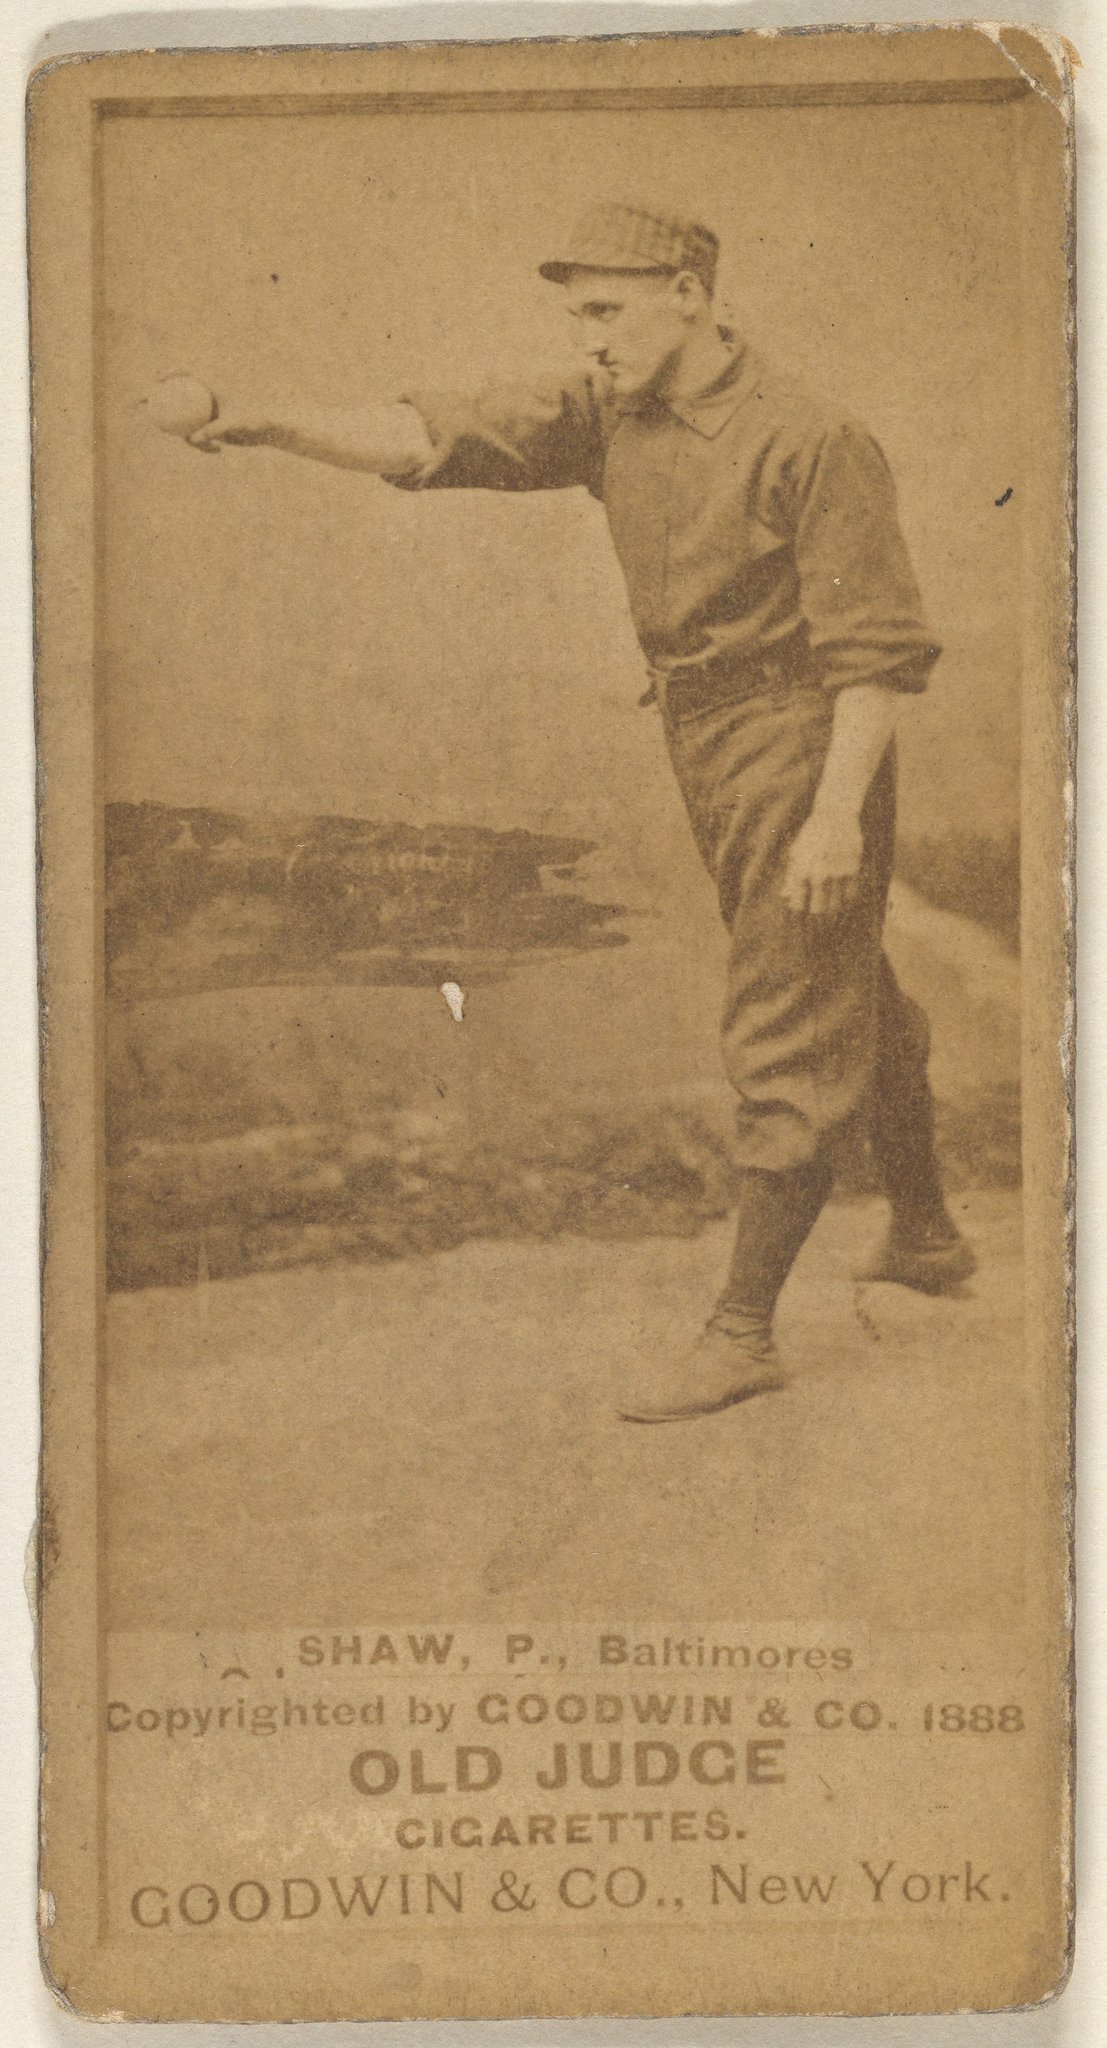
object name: baseball card, photograph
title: Shaw, Pitcher, Baltimore Orioles, from the Old Judge series (N172) for Old Judge Cigarettes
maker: goodwin & company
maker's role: publisher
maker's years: 1850-1950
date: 1888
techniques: albumen silver print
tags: men,portraits,baseball,athletes